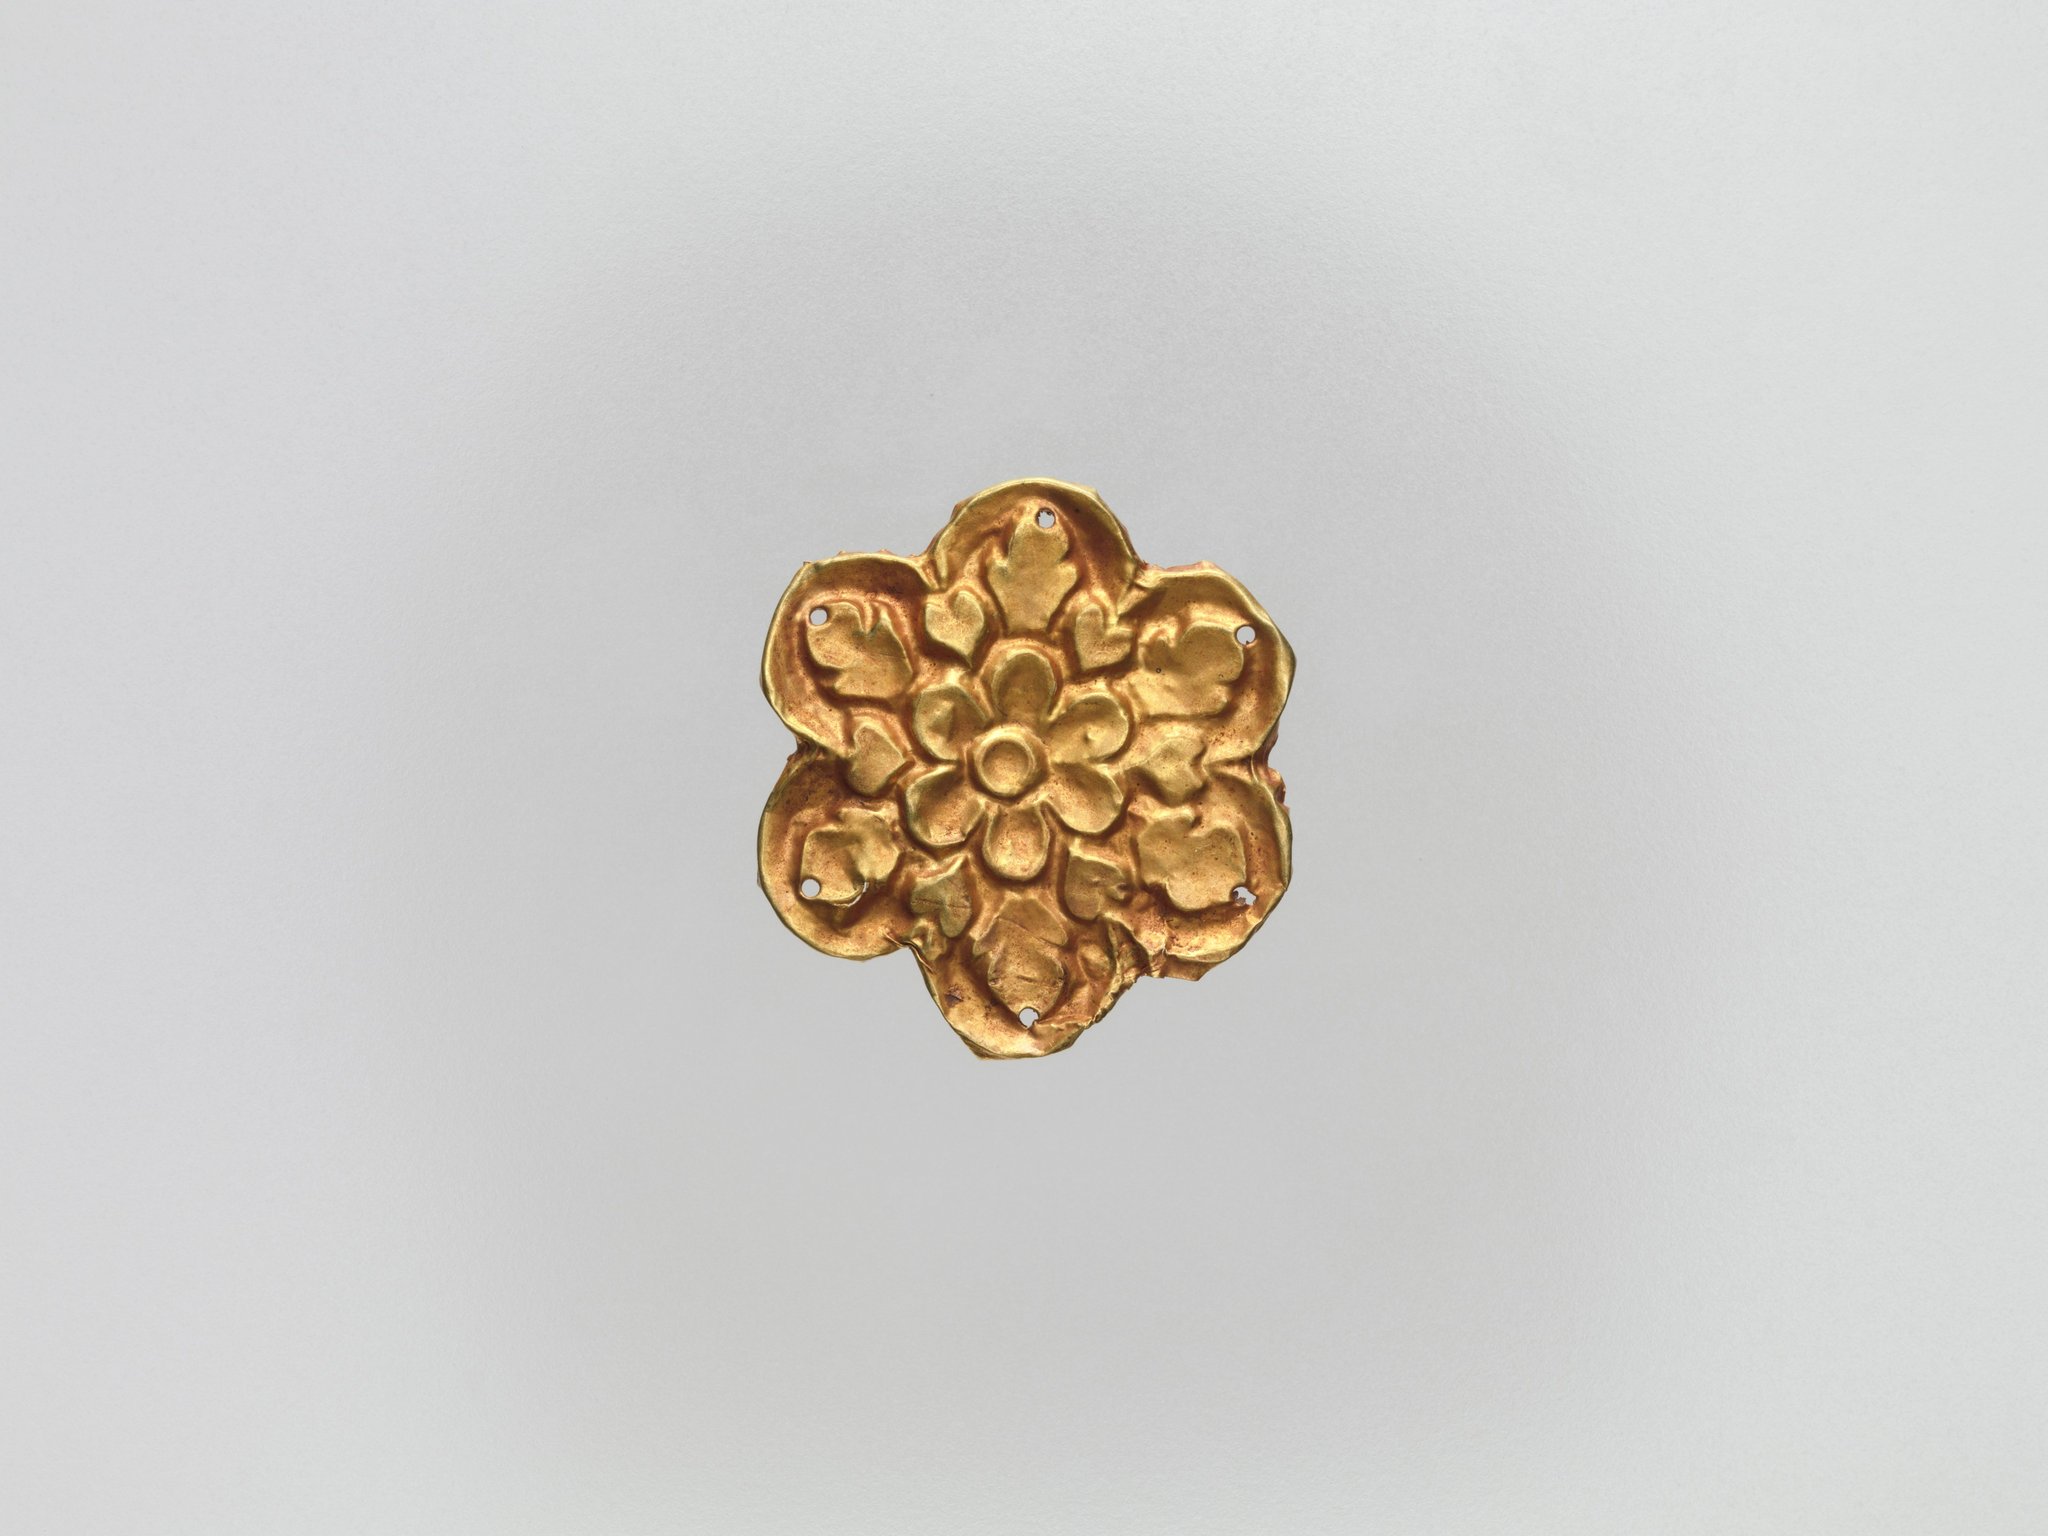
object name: garment plaque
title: Flower-Shaped Clothing Plaque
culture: chinese or central asian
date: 601-900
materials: gold